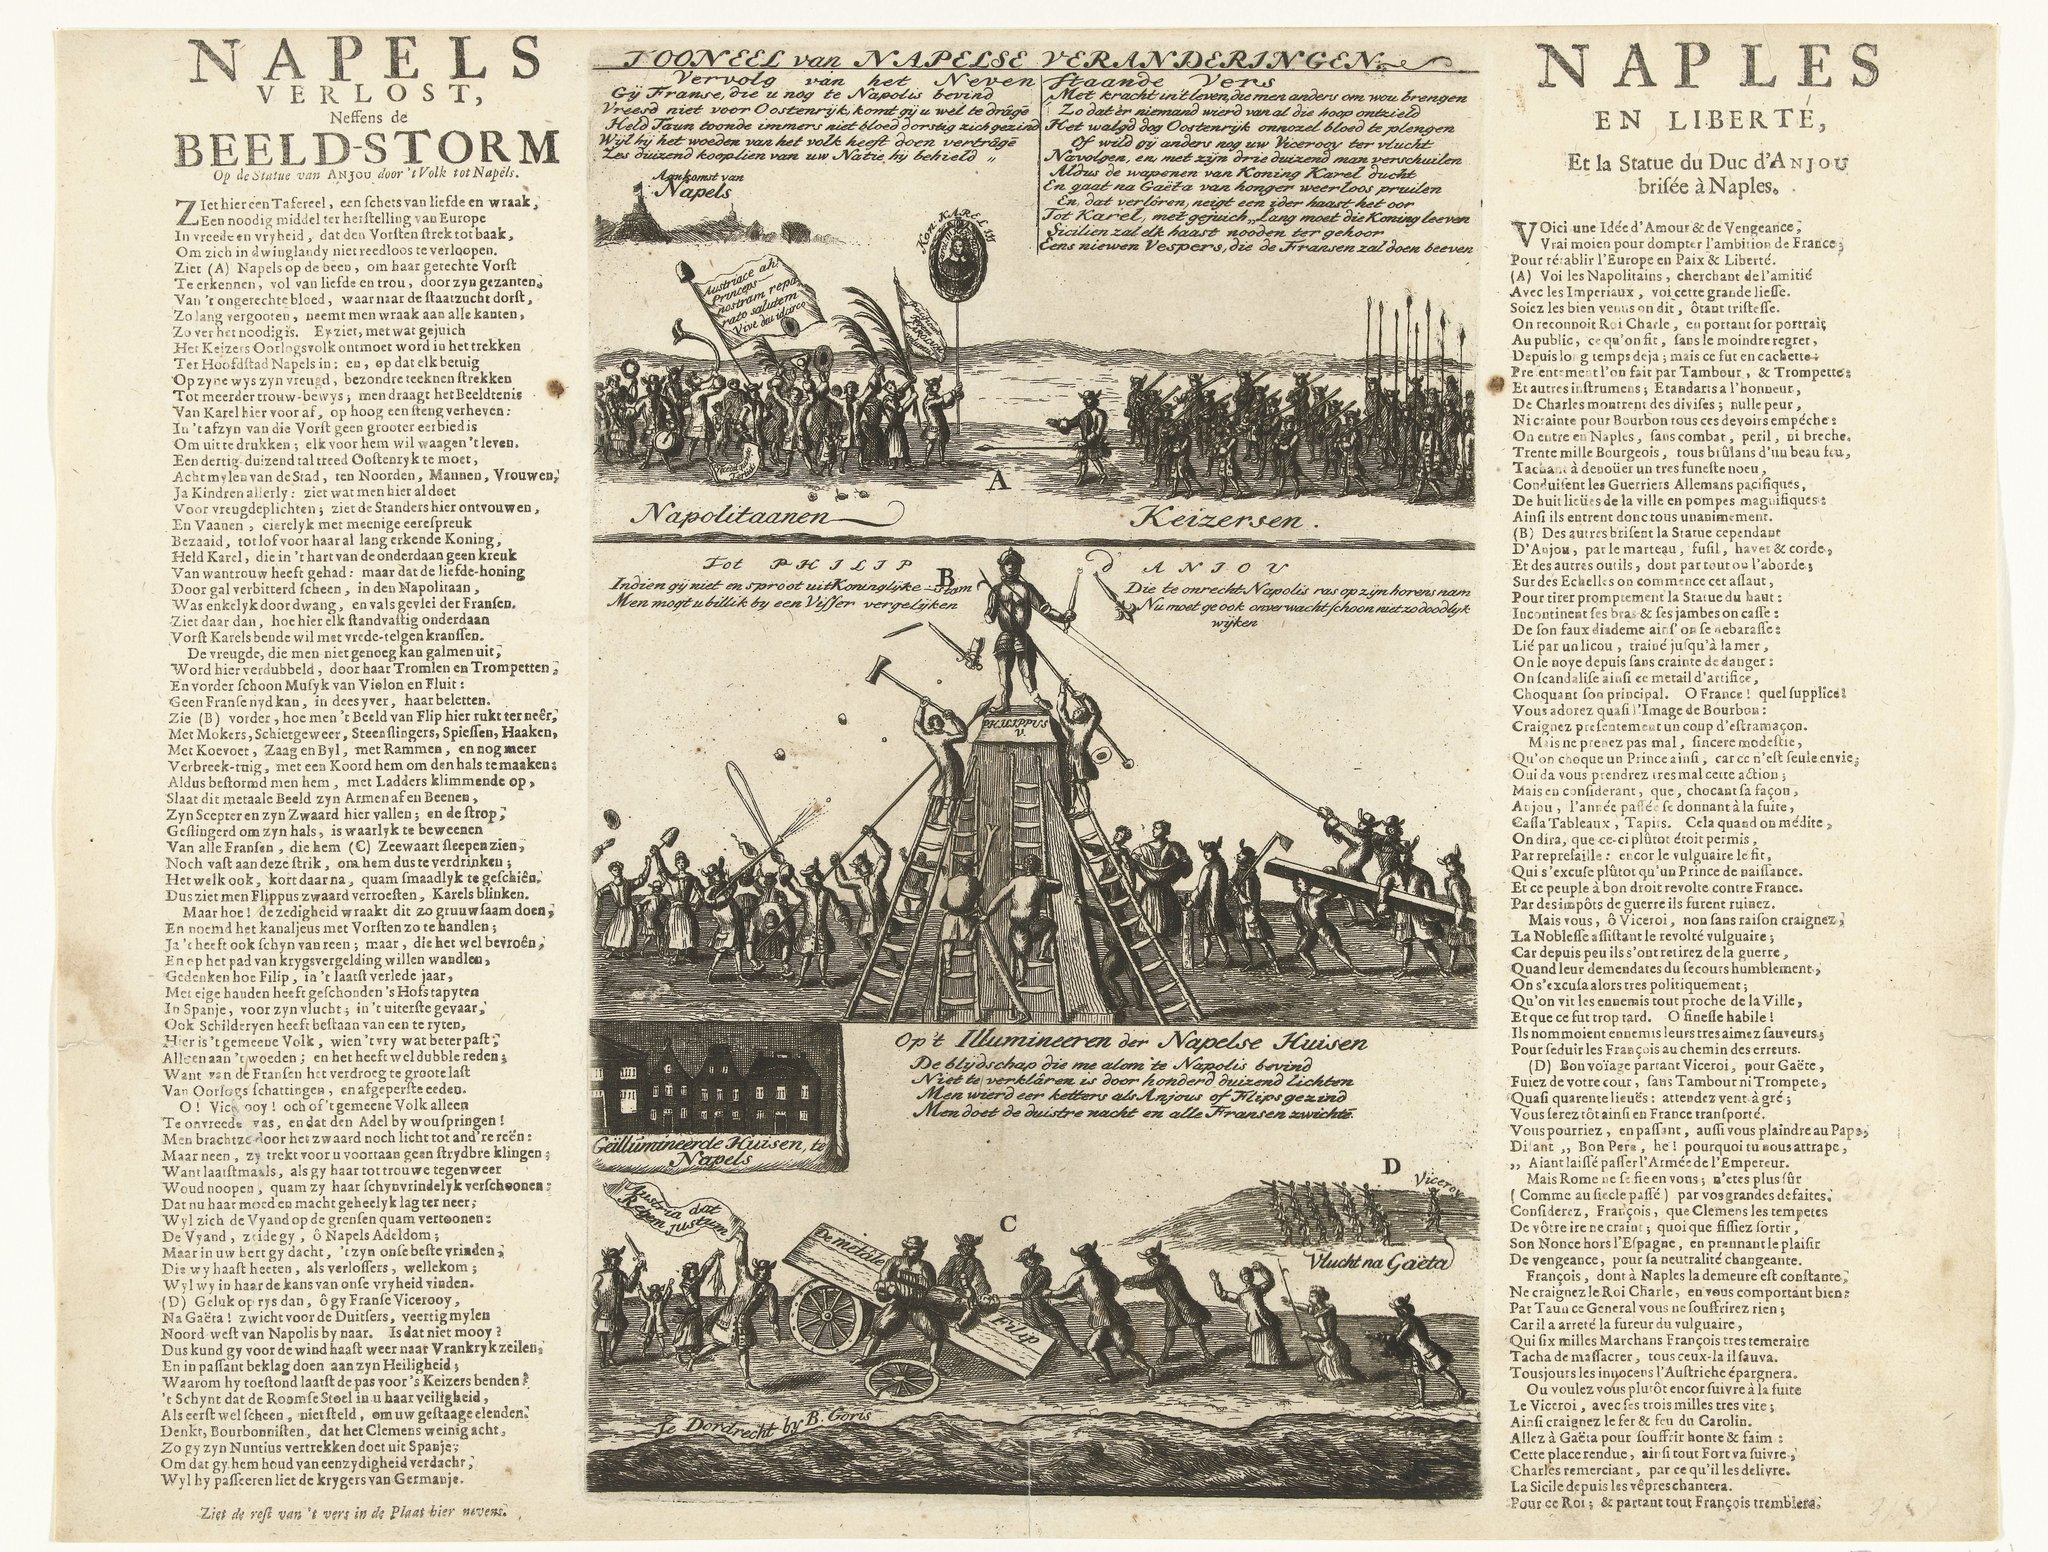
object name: print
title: Napels verlost, Neffens de Beeld-storm op de Statue van Anjou door 't Volk tot Napels / Napels en Liberté, Et la Statue du Duc d'Anjou brisée à Naples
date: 1707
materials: paper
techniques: etching, letterpress printing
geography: northern netherlands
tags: filips v (koning van spanje), charles vi (holy roman emperor), piece of sculpture, reproduction of a piece of sculpture (+ work of art damaged by iconoclasm), naples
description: Omwentelingen te Napels ten gunste van Karel III (keizer Karel VI). Plaat met drie voorstellingen. Boven: de Napolitanen komen de keizerlijke troepen tegemoet. Midden: afbreken van het standbeeld van de hertog van Anjou (Filips V) te Napels. Onder: wegvoeren van de stukken van het beeld en verlichte huizen te Napels. Op het blad aan weerszijden van de plaat verzen in het Nederlands en Frans. Spotprent op de situatie in het jaar 1707 in de Spaanse Successieoorlog. Onderdeel van een reeks van 7 spotprenten op de Fransen en bondgenoten uit het jaar 1707.